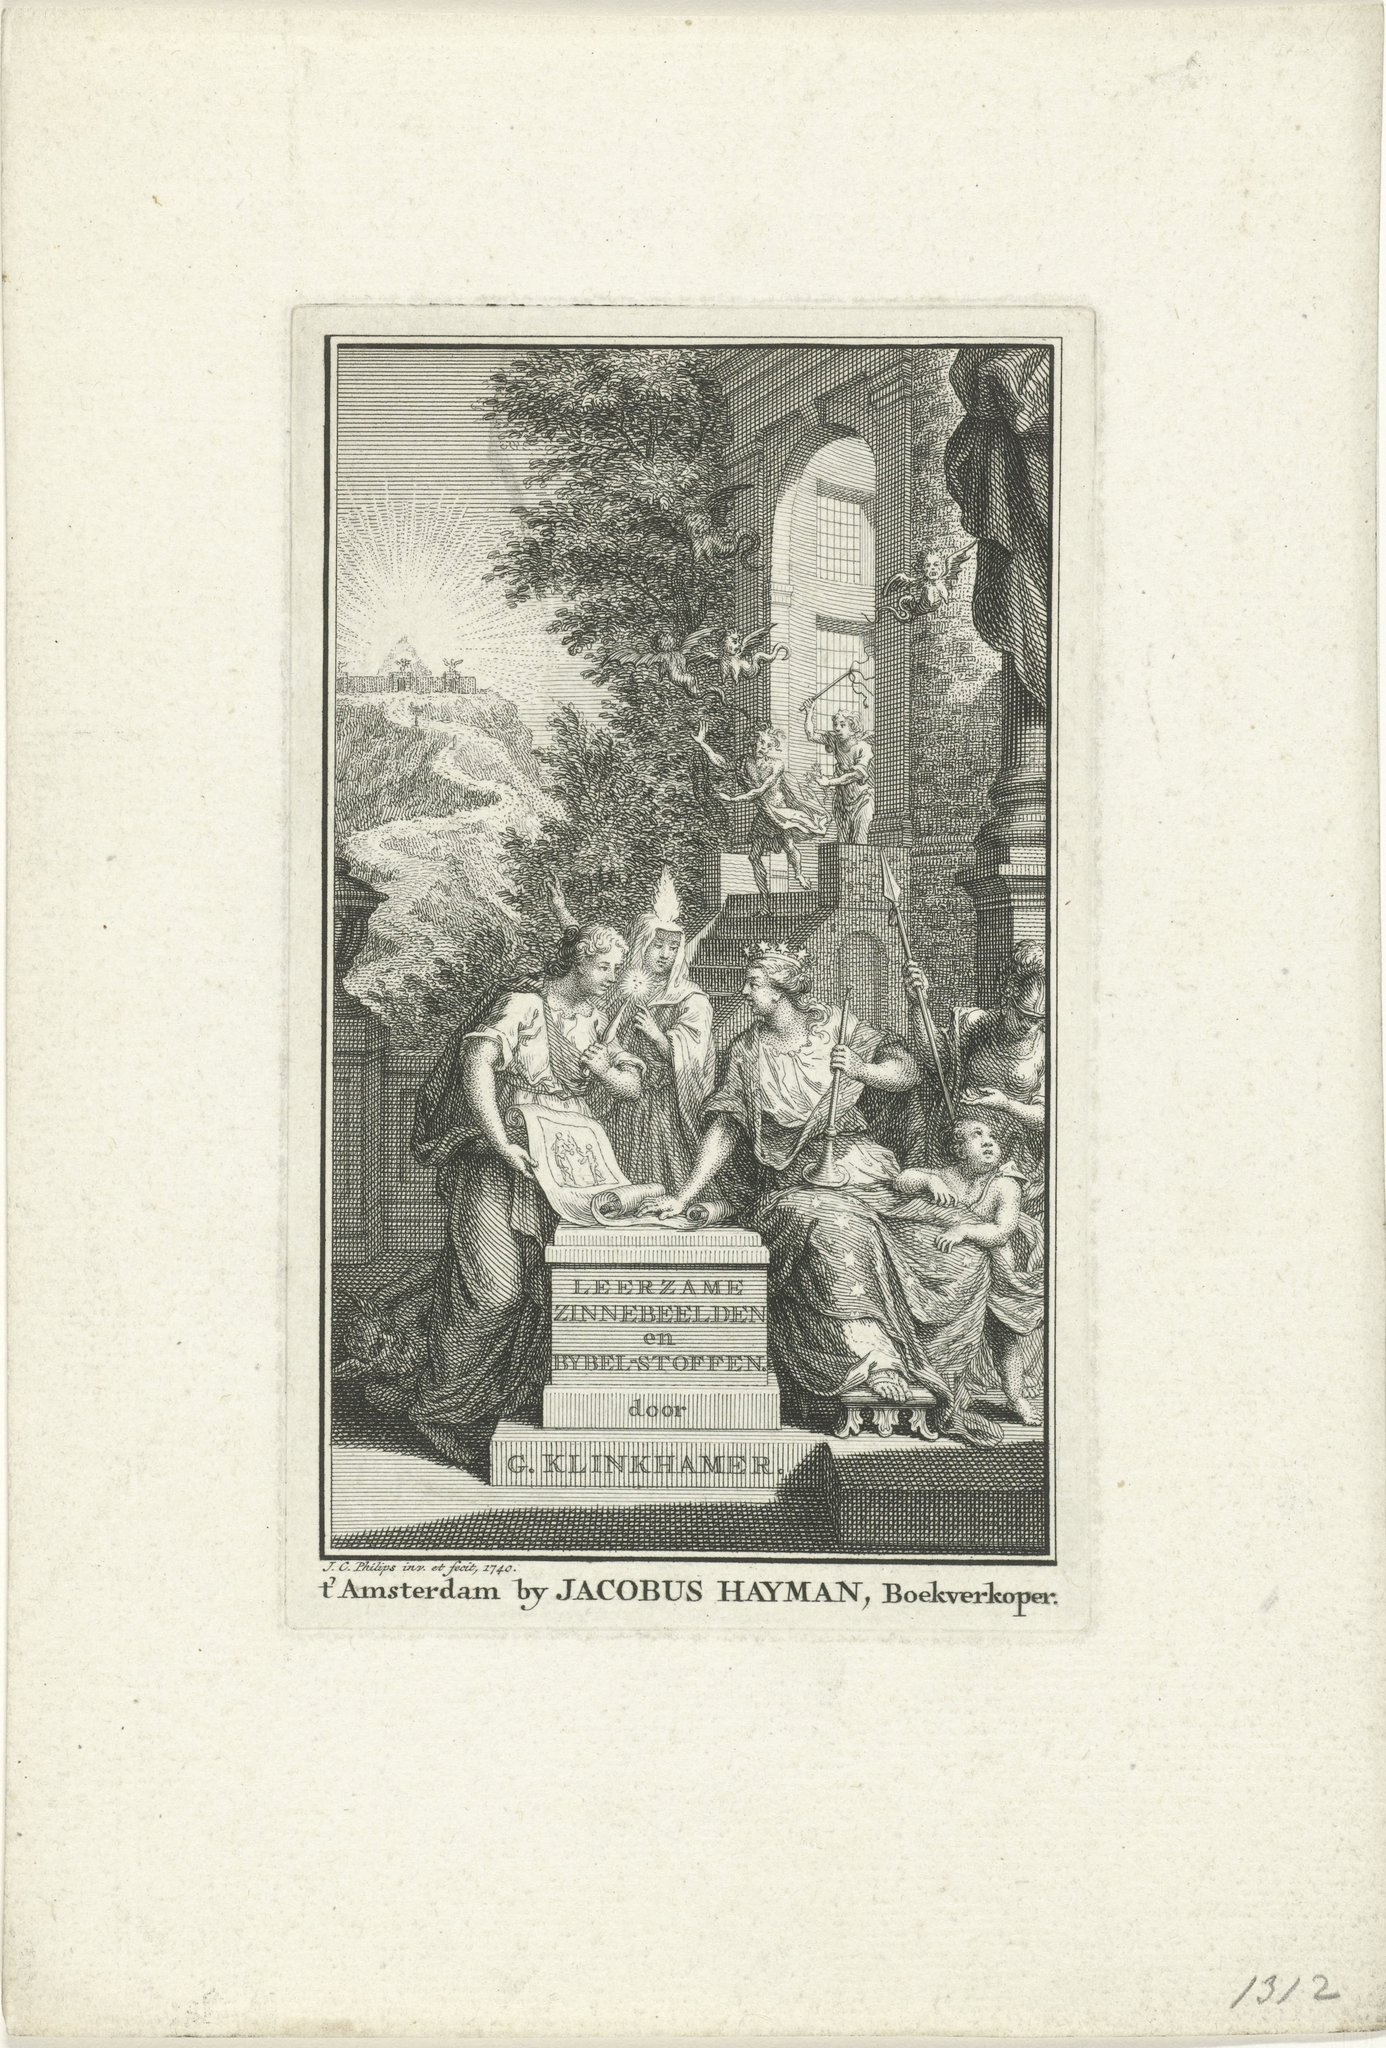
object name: print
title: Waarheid en Poëzie in gesprek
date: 1740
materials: paper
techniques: engraving, etching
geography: amsterdam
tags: minerva as patroness, devil(s) and demons, truth; 'verità' (ripa), symbolic representations, allegories and emblems ~ poetry; 'poesia' (ripa)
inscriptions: collector's mark: Lugt 2228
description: Waarheid en Poëzie, vergezeld door Minerva, in gesprek bij een altaar waarop de titel in het Nederlands. Een engel, met vlam boven het hoofd als symbool voor geloofsijver, wijst hen op het hemelse Jeruzalem. Links op de voorgrond een duivel die hen bespiedt. Rechts op de achtergrond een vrouw die duivels met haar gesel het huis uitjaagt.